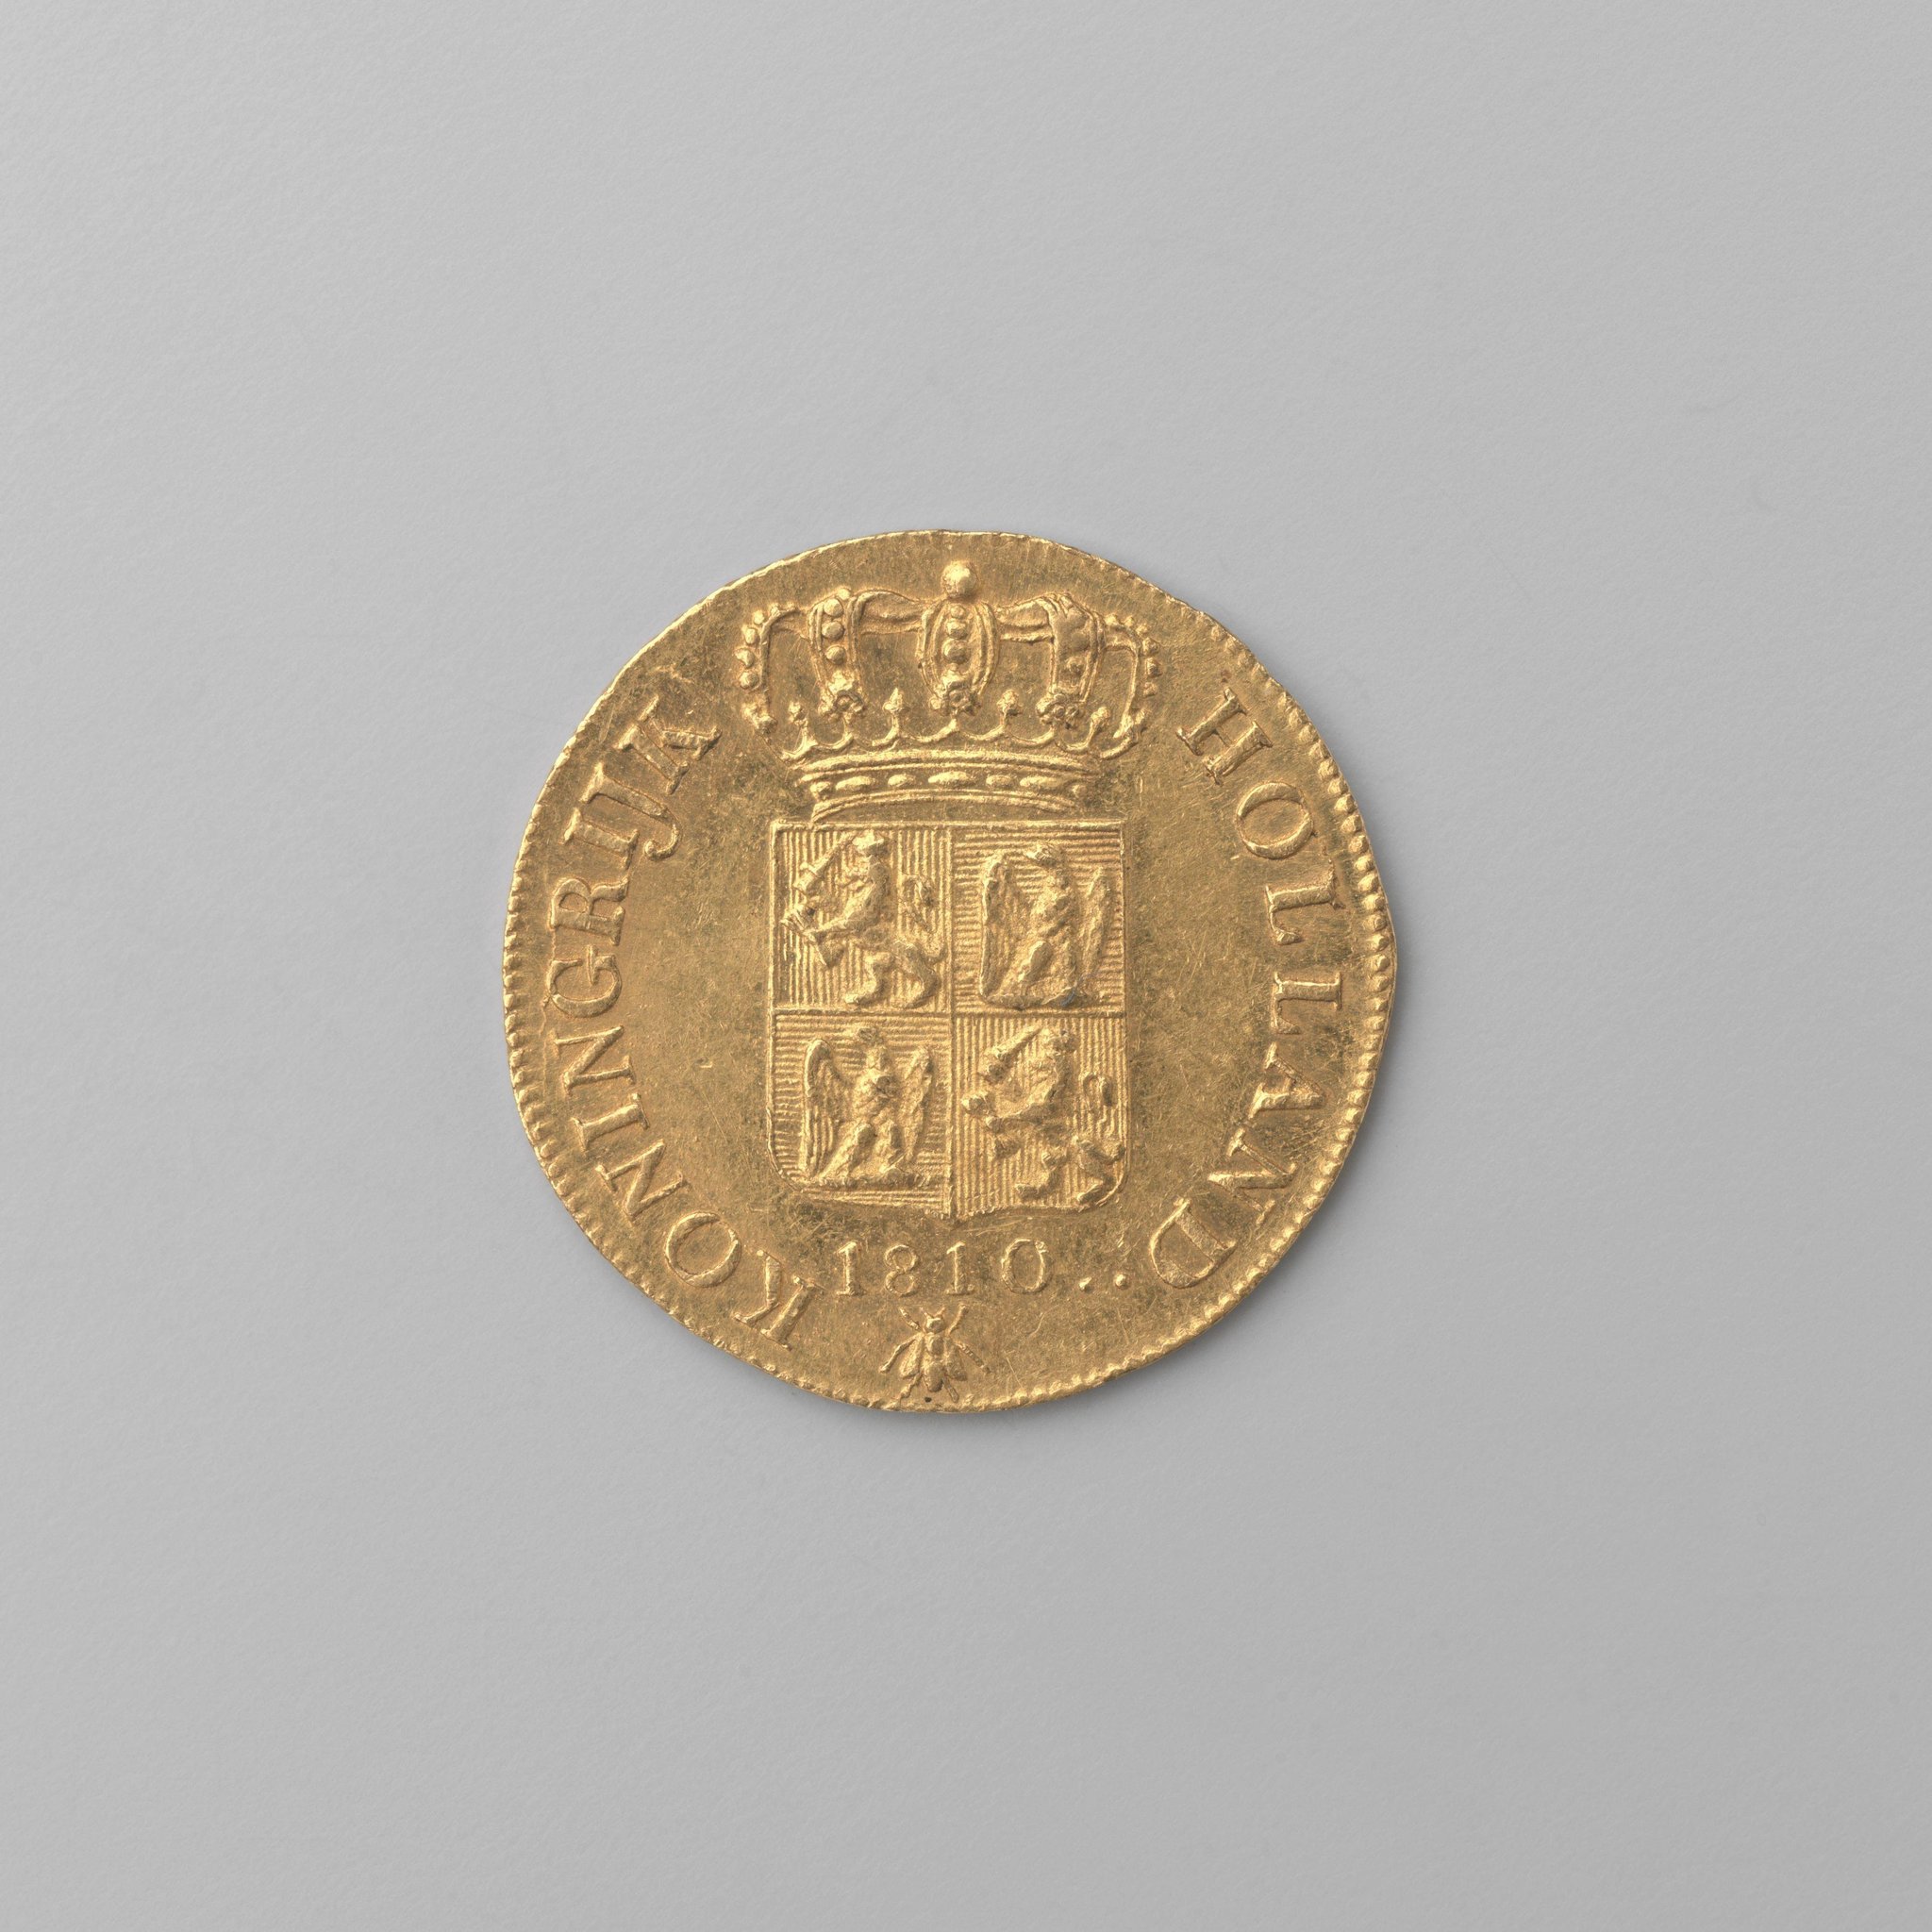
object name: coin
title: Koninkrijk Holland, dukaat, 1810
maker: louis napoleon (king of holland)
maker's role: koning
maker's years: 1778-1846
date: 1810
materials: gold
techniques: striking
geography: utrecht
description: Gouden munt. Voorzijde: borstbeeld van de koning naar links. Keerzijde: gekroond wapenschild, waaronder jaartal. Daaronder muntmeesterteken. Kabelrand.